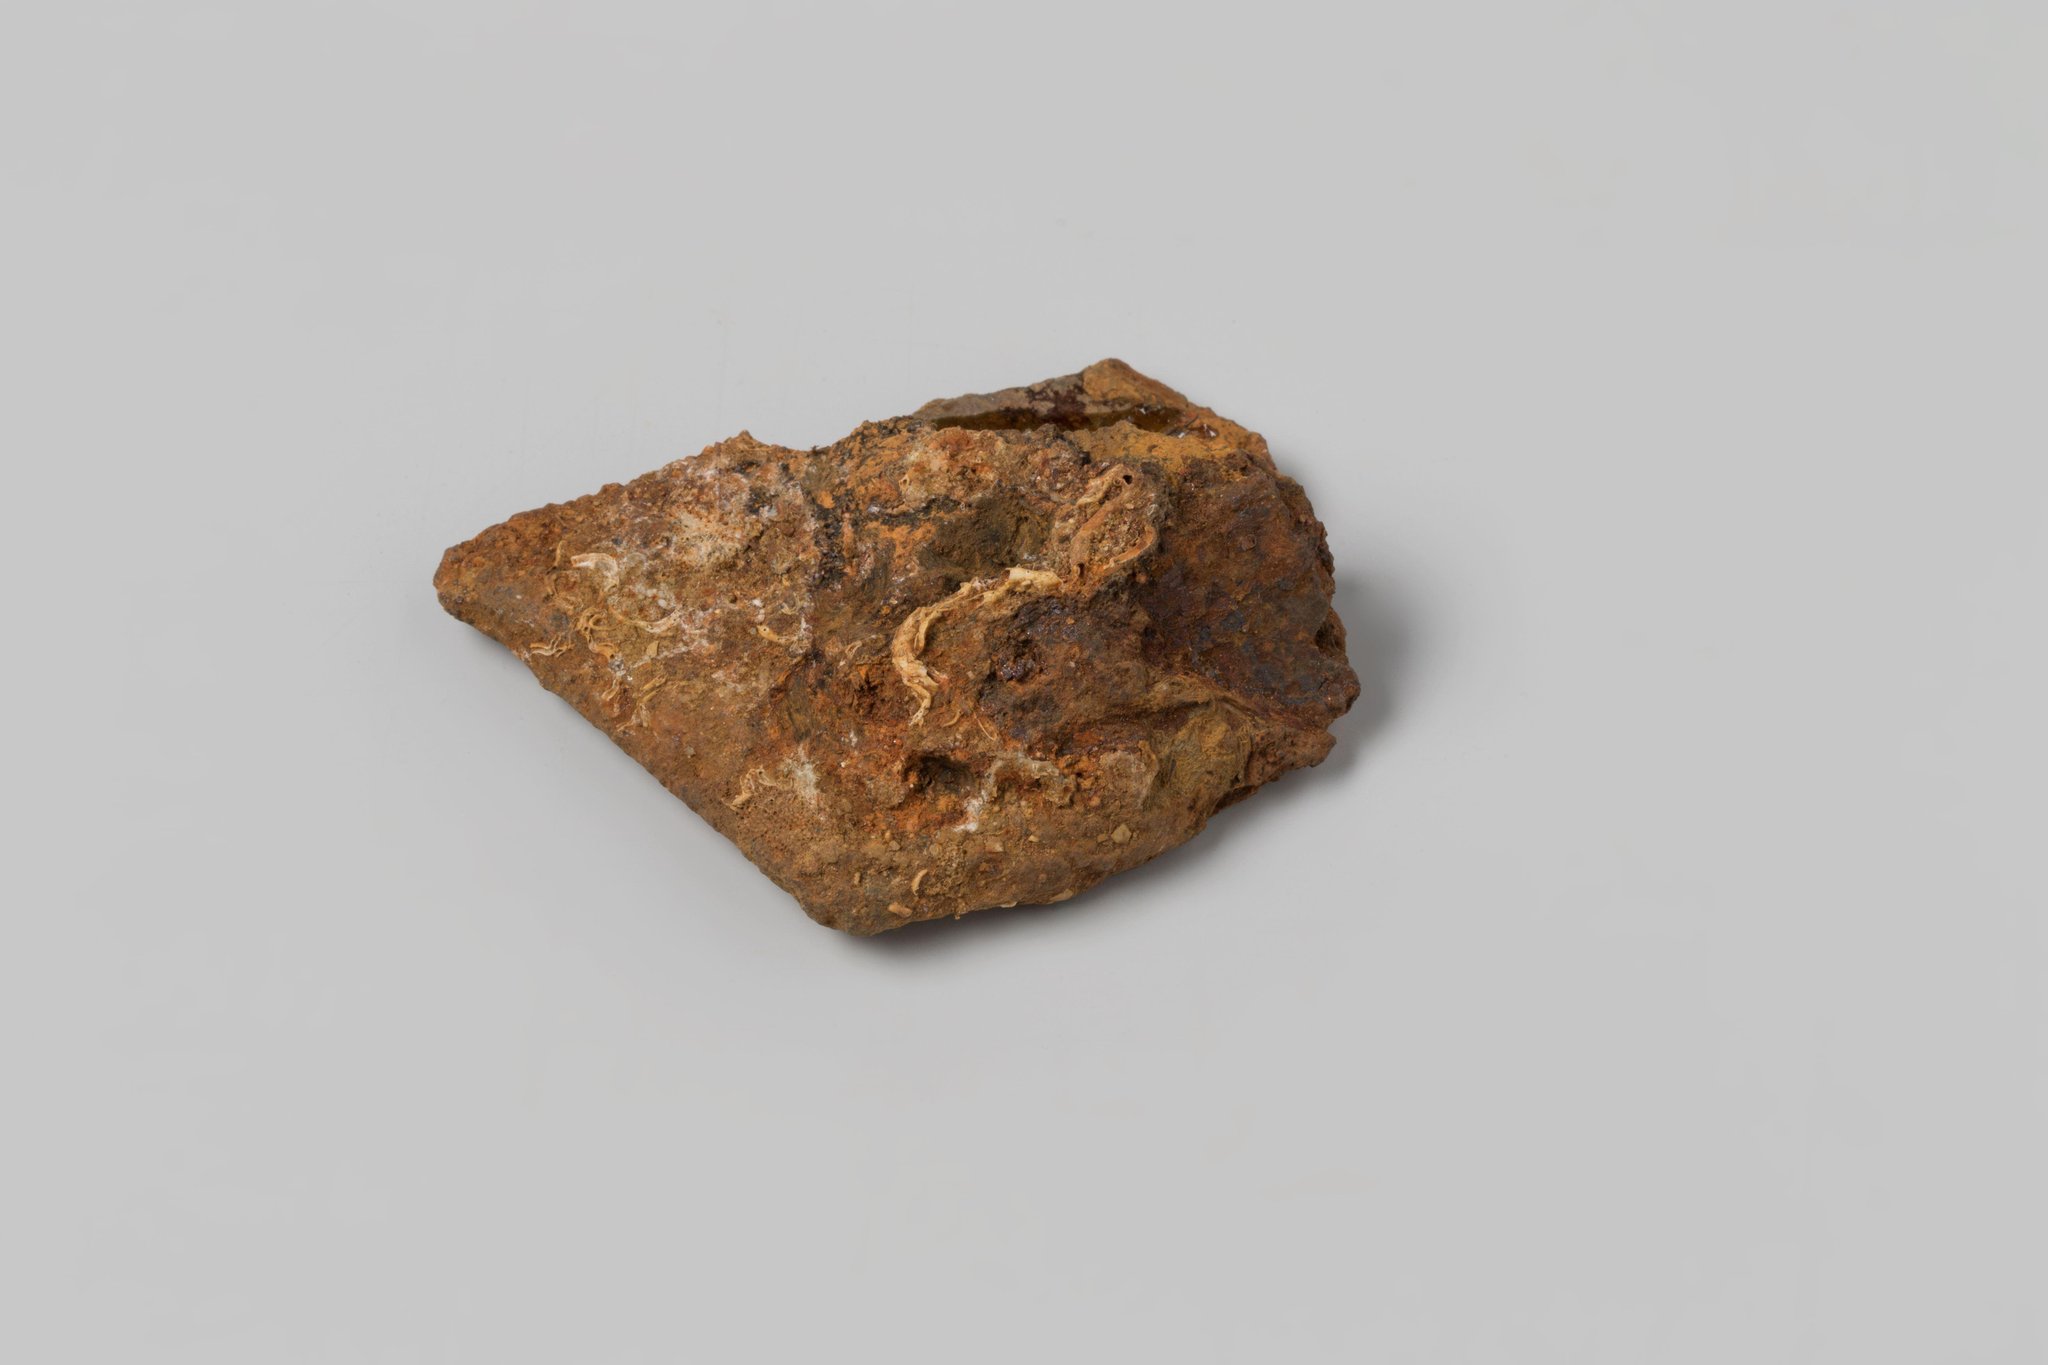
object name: scheepswrakvondst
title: Fragment leisteen uit het wrak van de Oost-Indiëvaarder Hollandia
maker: Anonymous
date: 1700-1743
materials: stone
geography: netherlands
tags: verenigde oostindische compagnie, hollandia (schip), annet